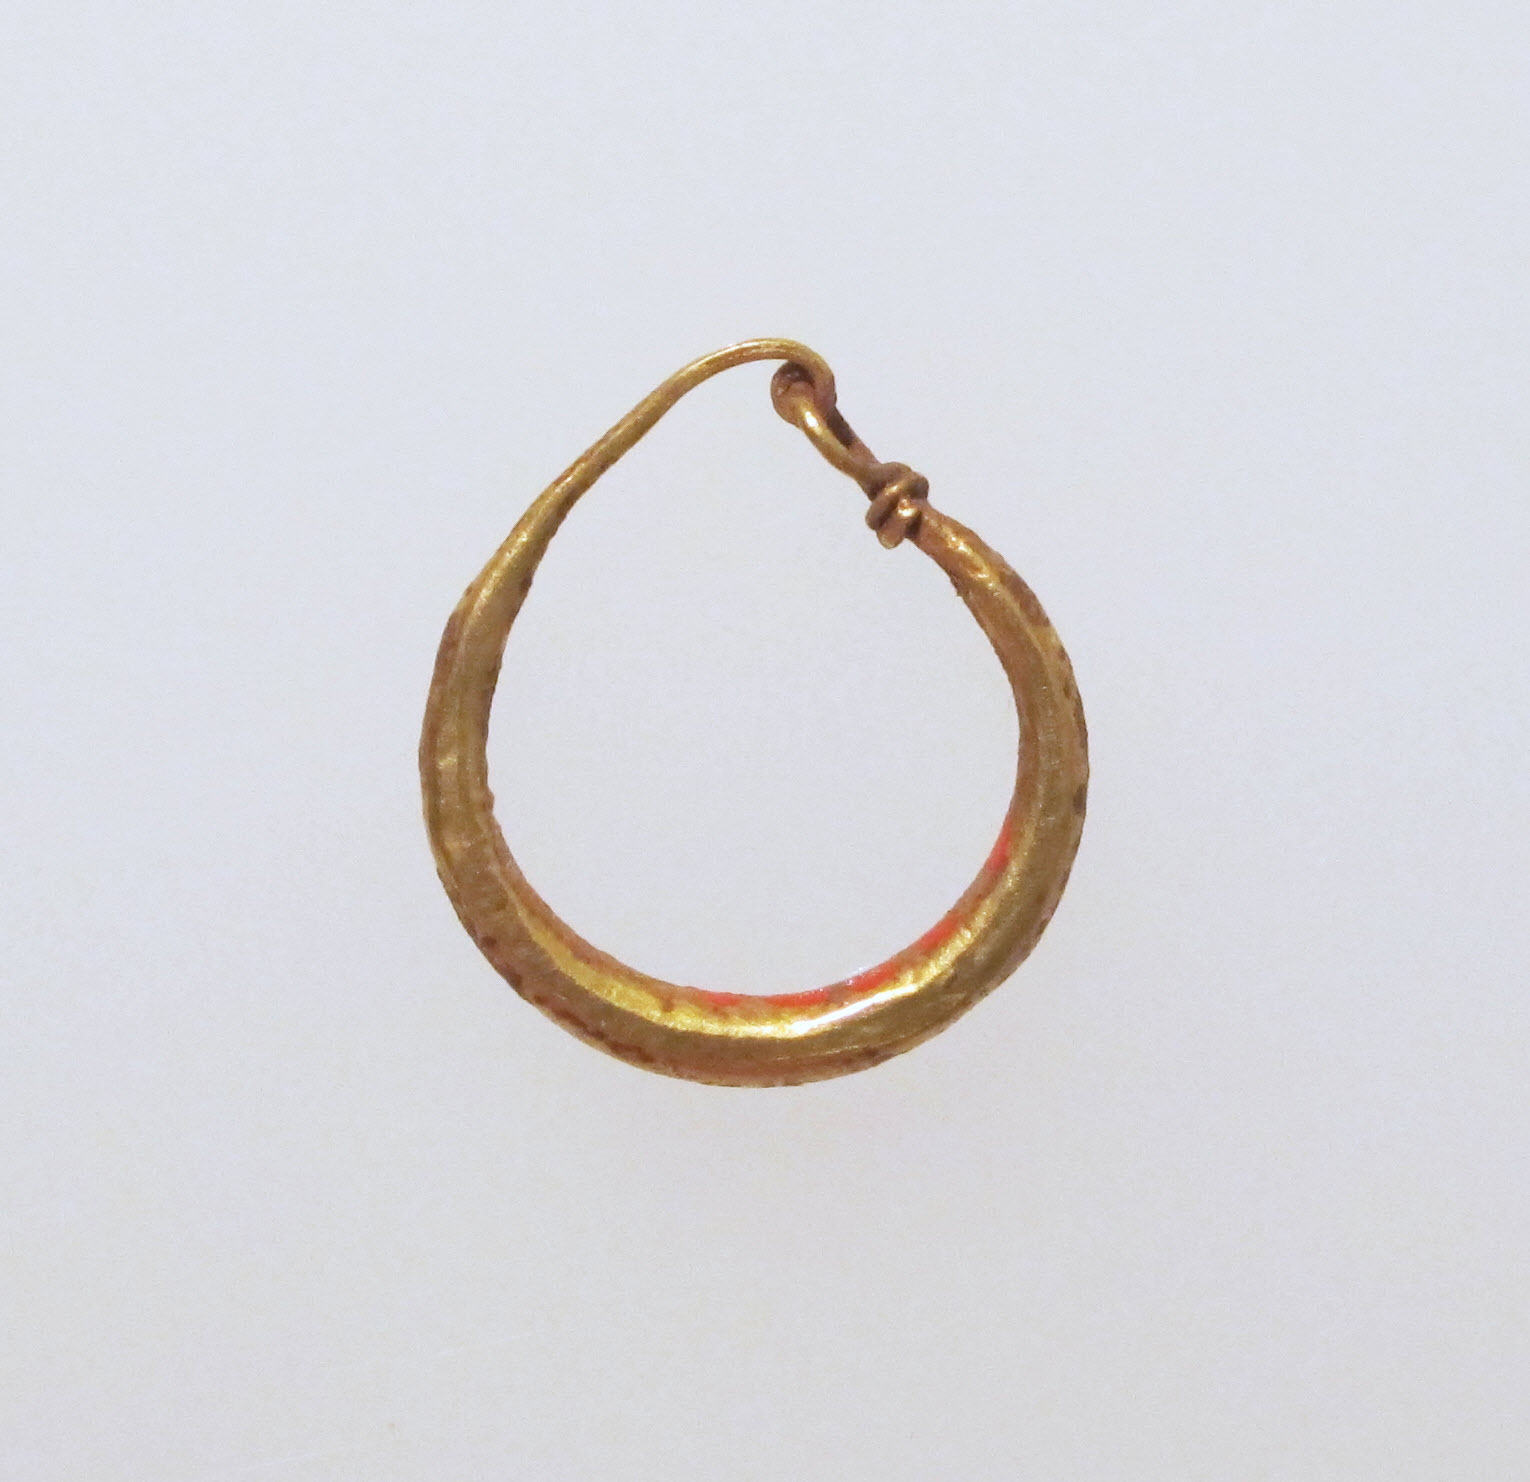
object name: earring loop type, plain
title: Earring-loop type, plain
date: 7000 BCE-330 CE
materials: gold